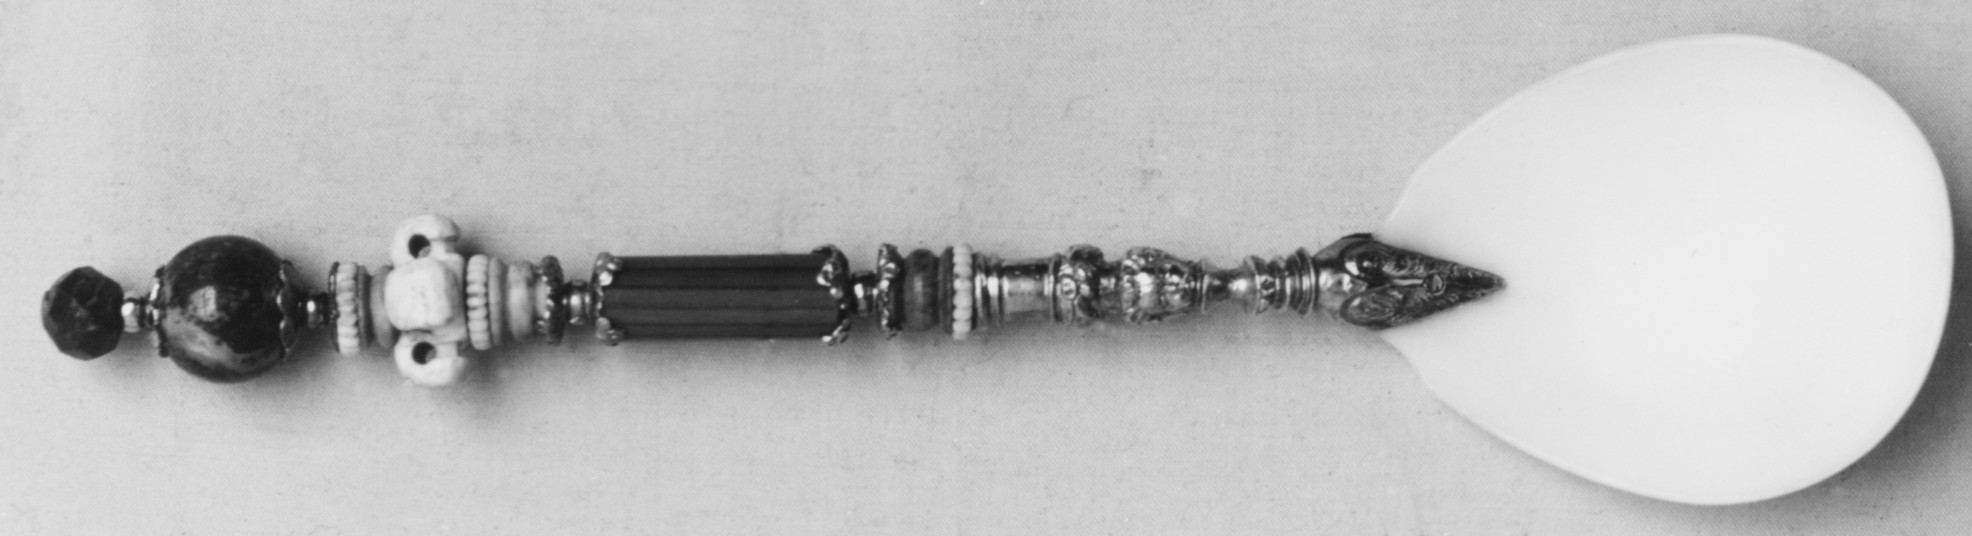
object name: spoon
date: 1601-1700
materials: shell, silver gilt